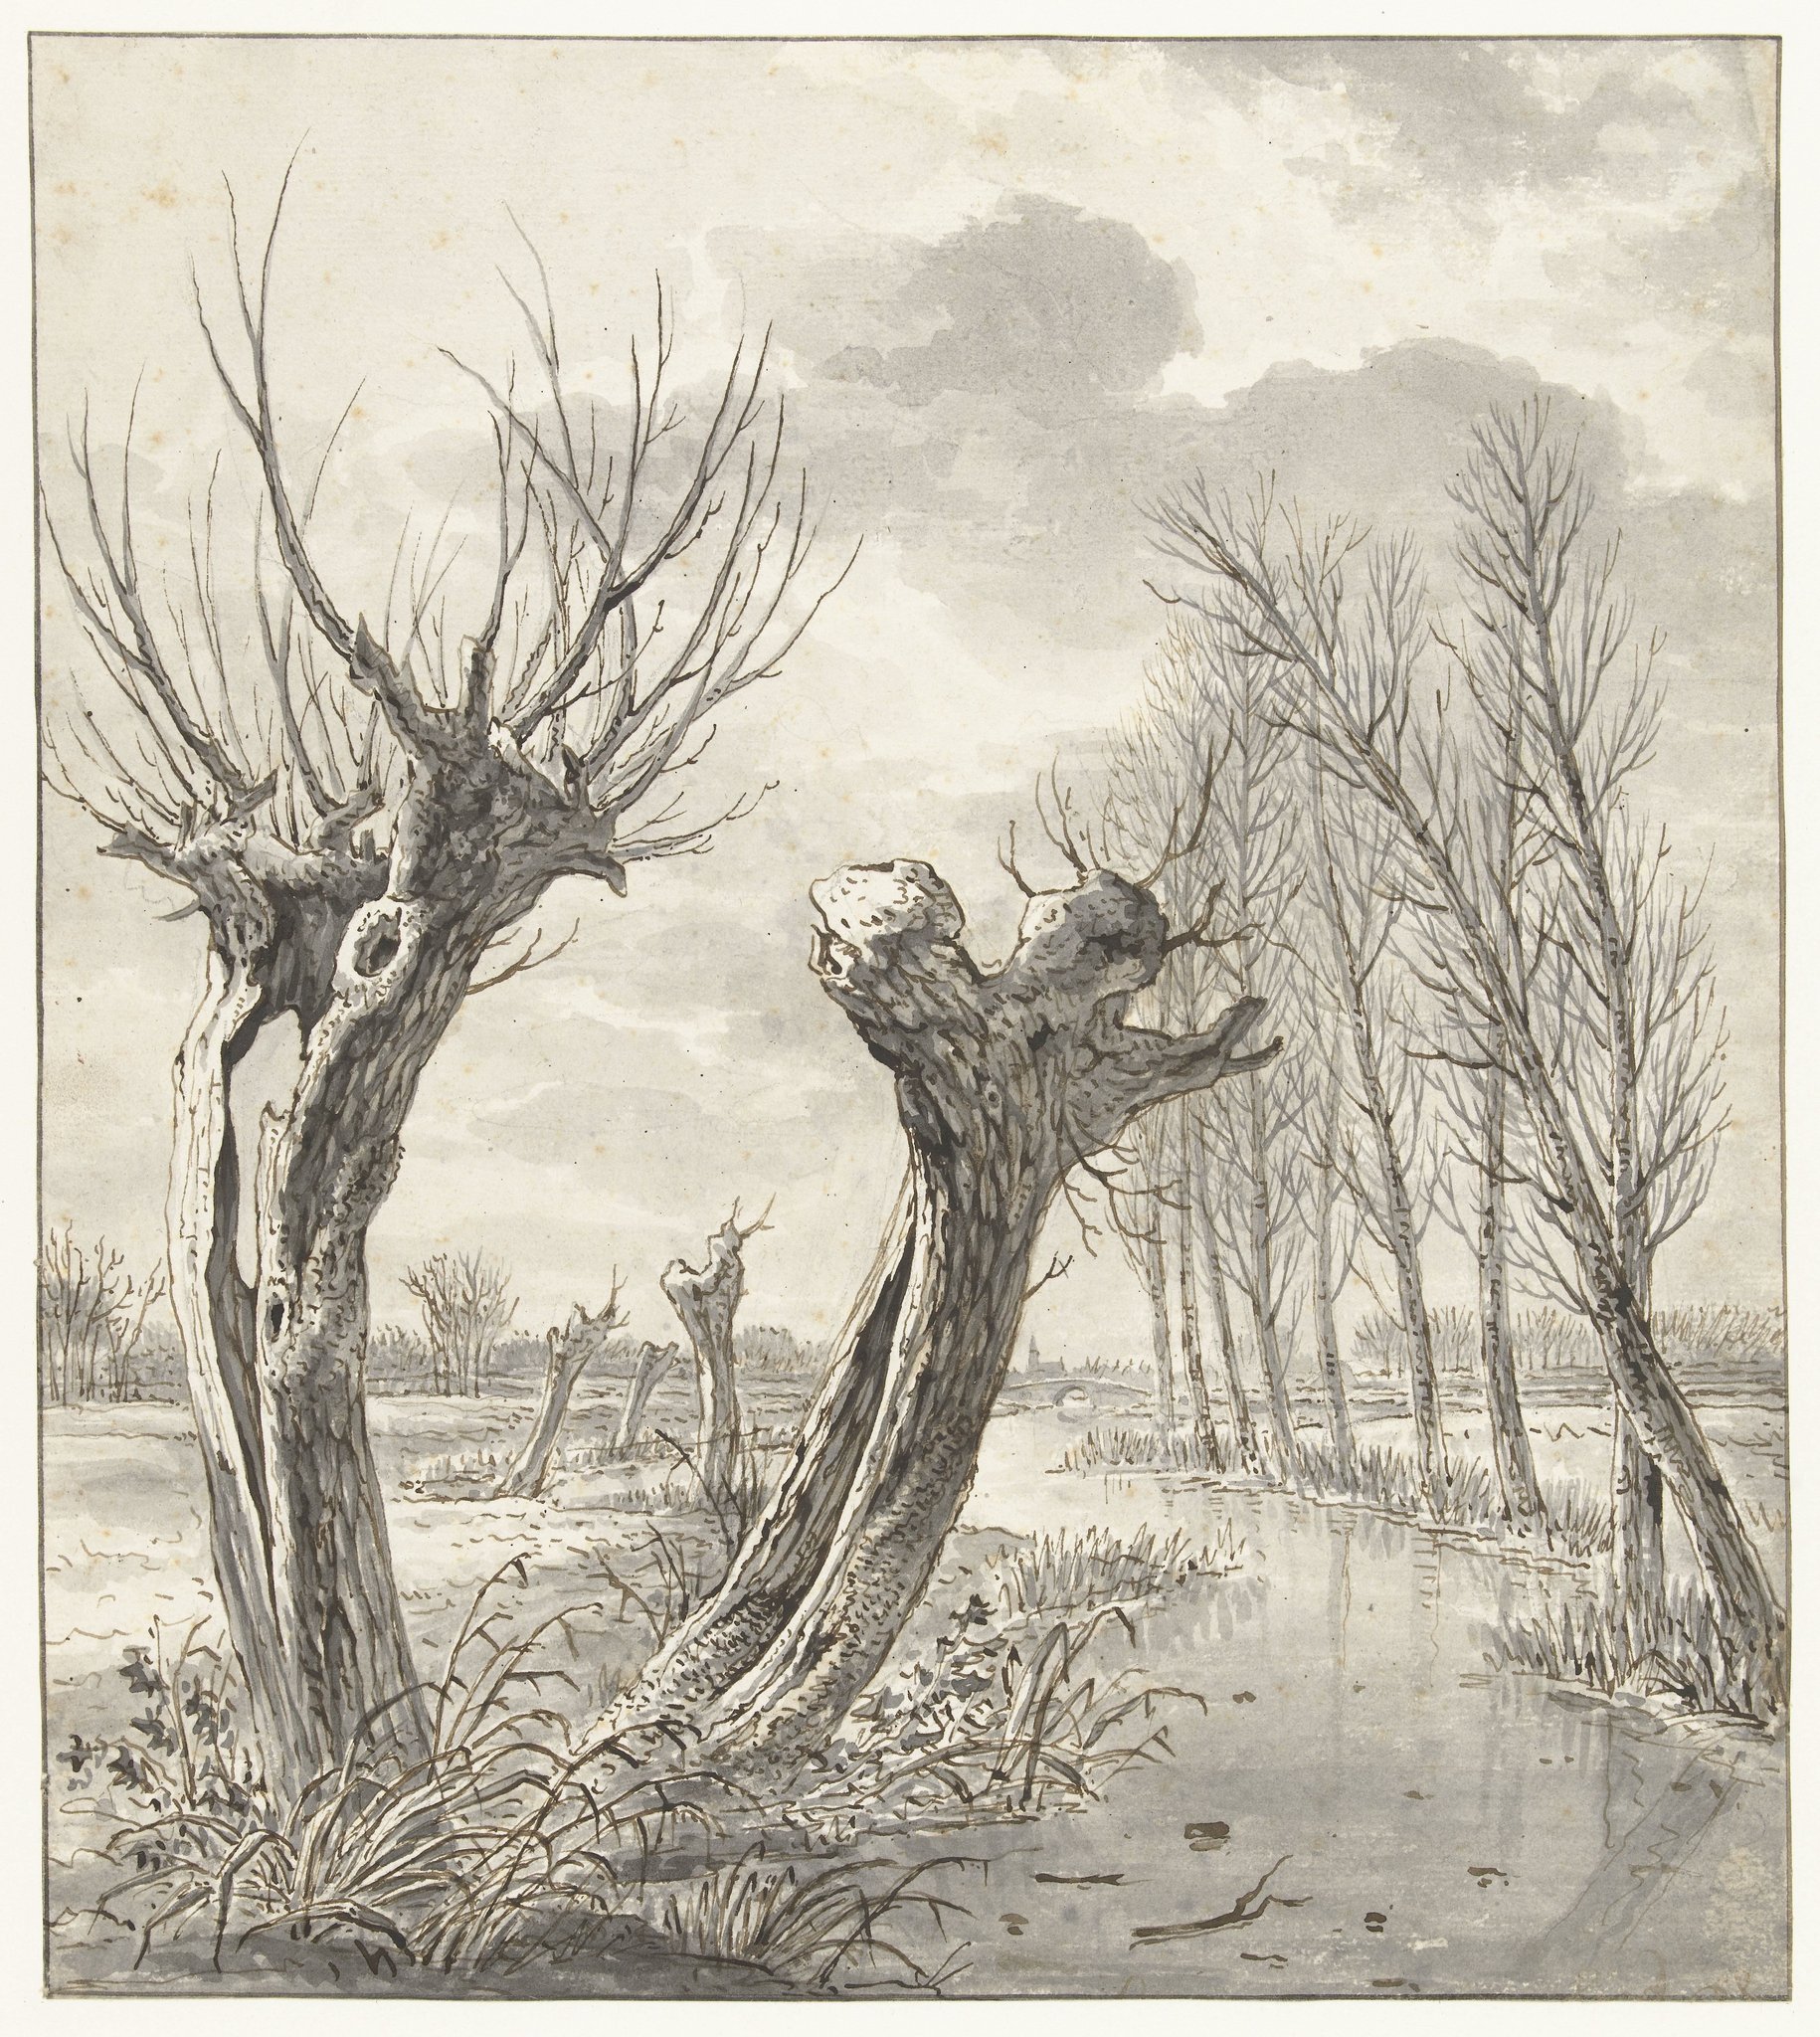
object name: drawing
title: Winterlandschap met knotwilgen langs een bevroren sloot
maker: jacob van strij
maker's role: draughtsman, painter, print maker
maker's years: 1756-1815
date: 1766-1815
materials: ink, paper, watercolor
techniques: brush, pen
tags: underground structures in city, trees: willow, small canal, ditch